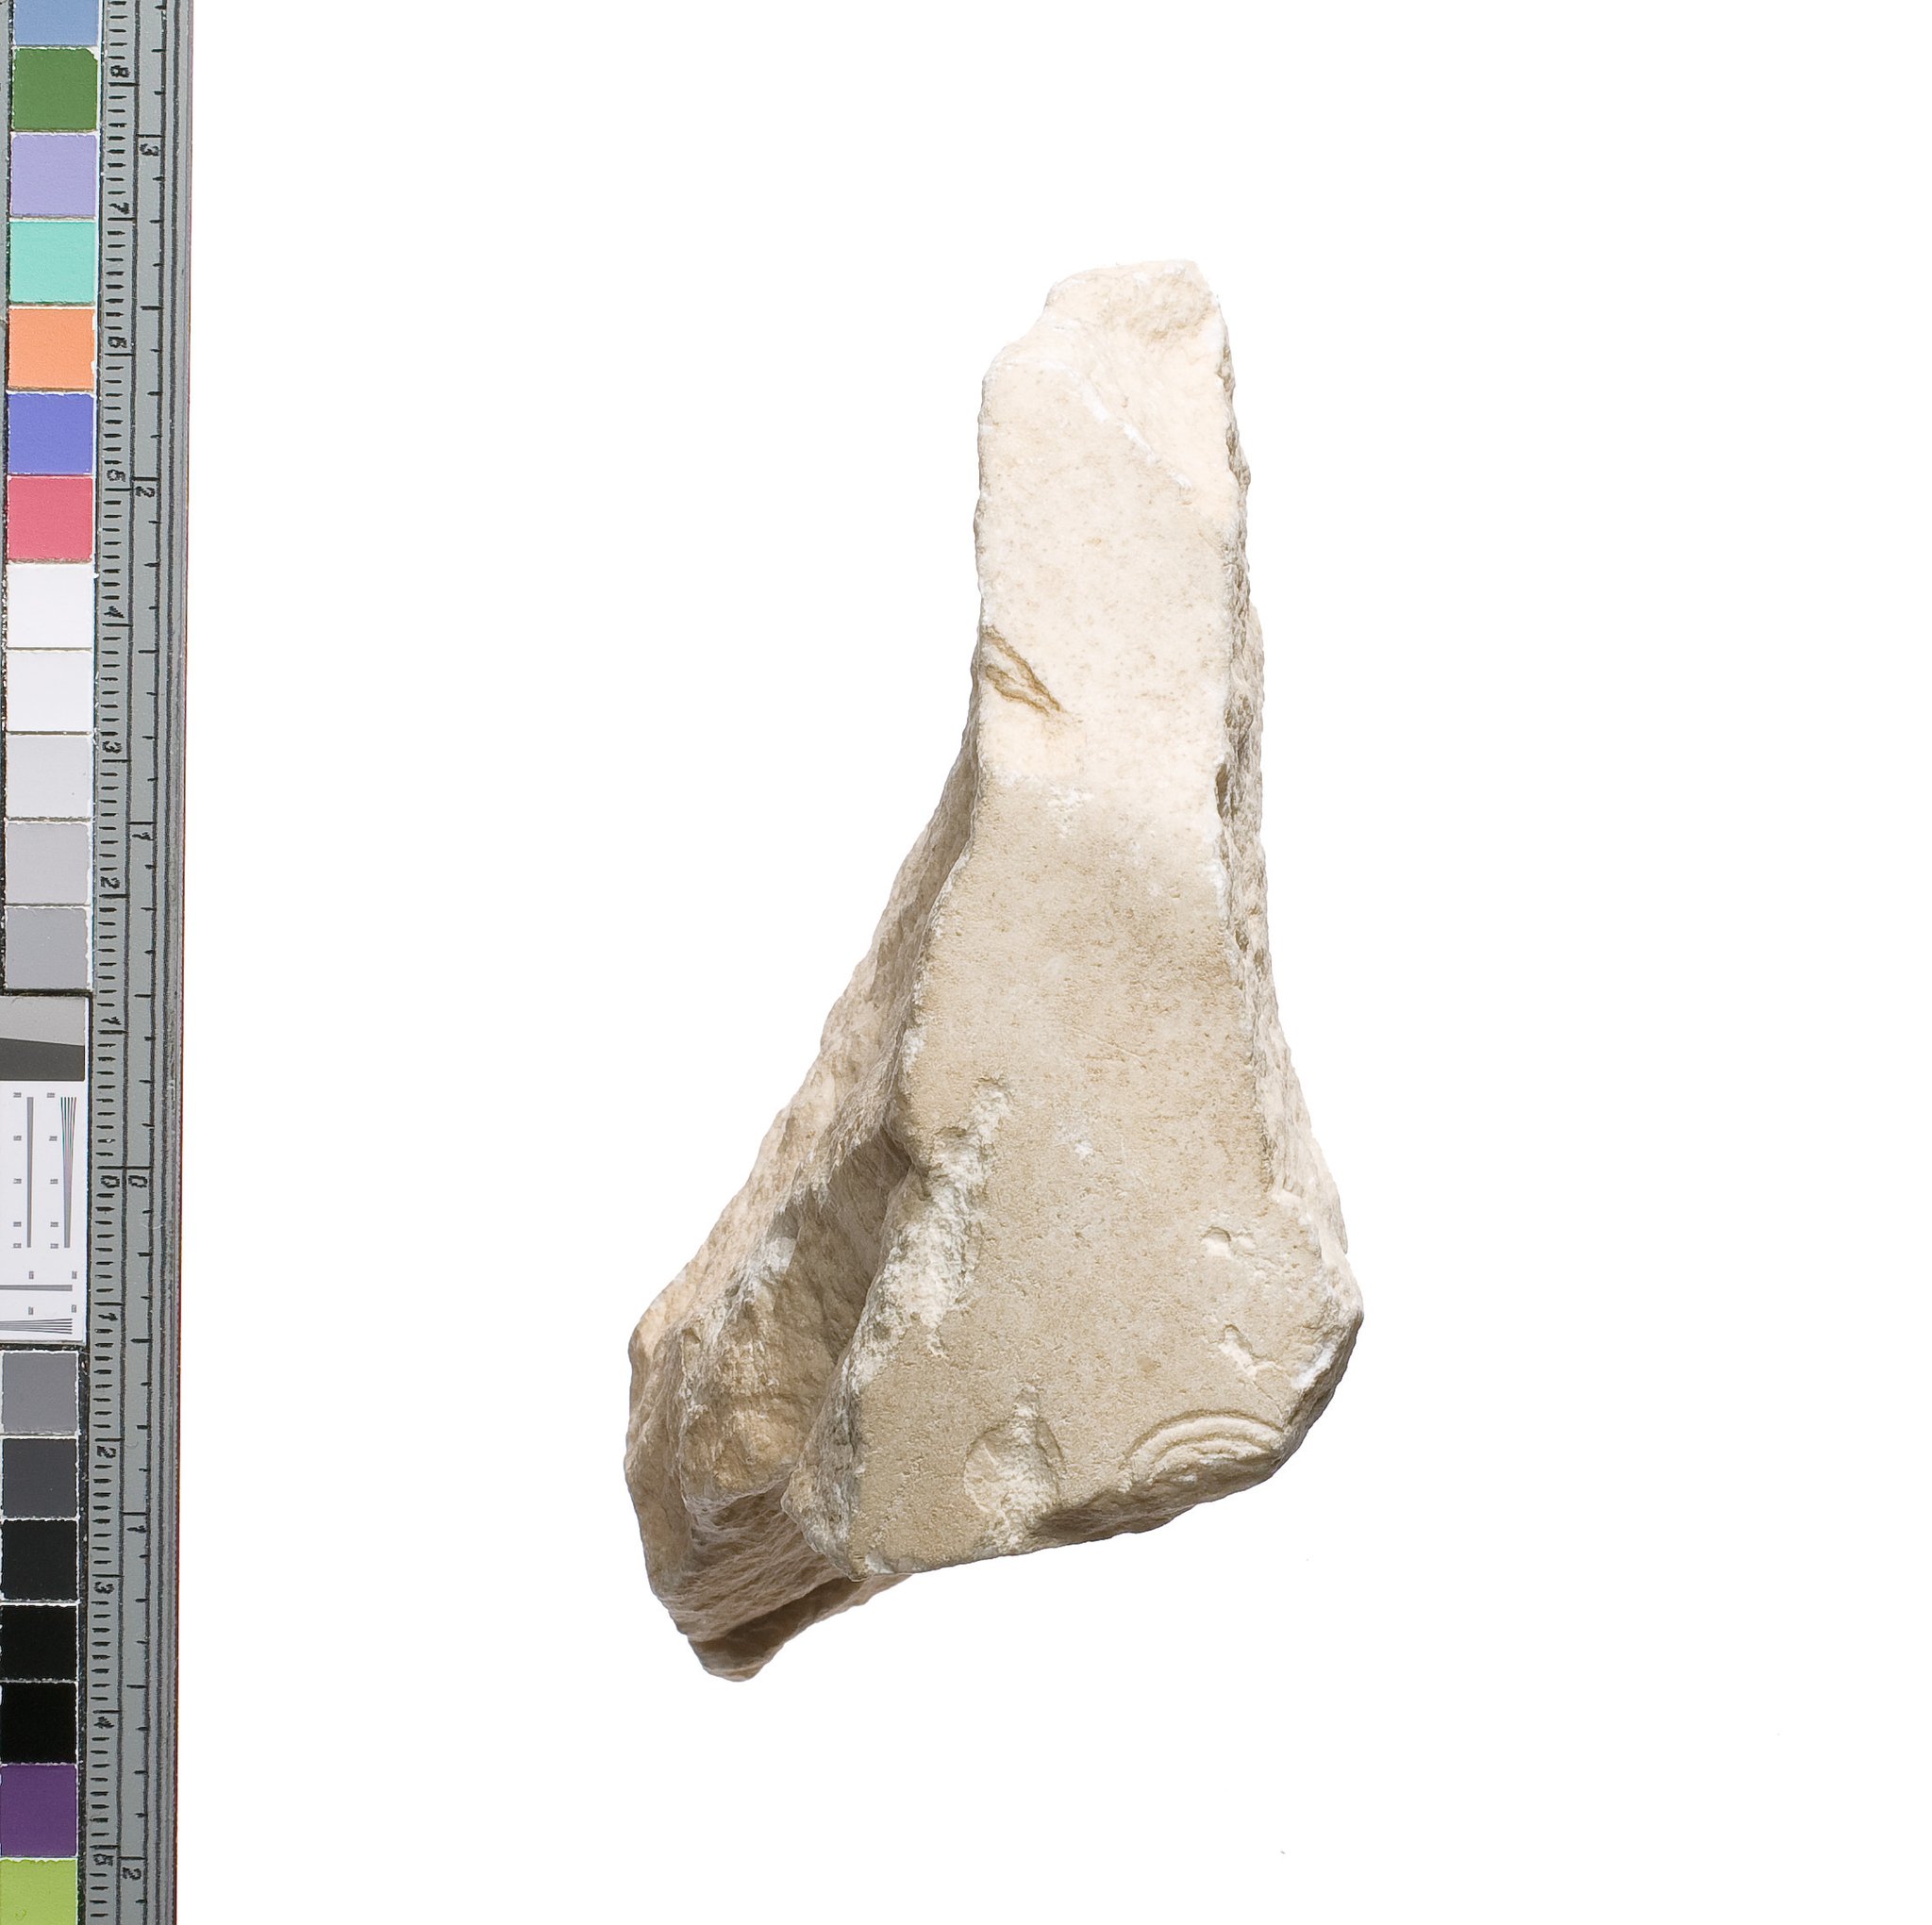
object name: right shoulder area, garment, pleating, cartouche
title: Right shoulder slice with shawl traces and Aten cartouche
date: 1353-1336 BCE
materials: limestone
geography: egypt